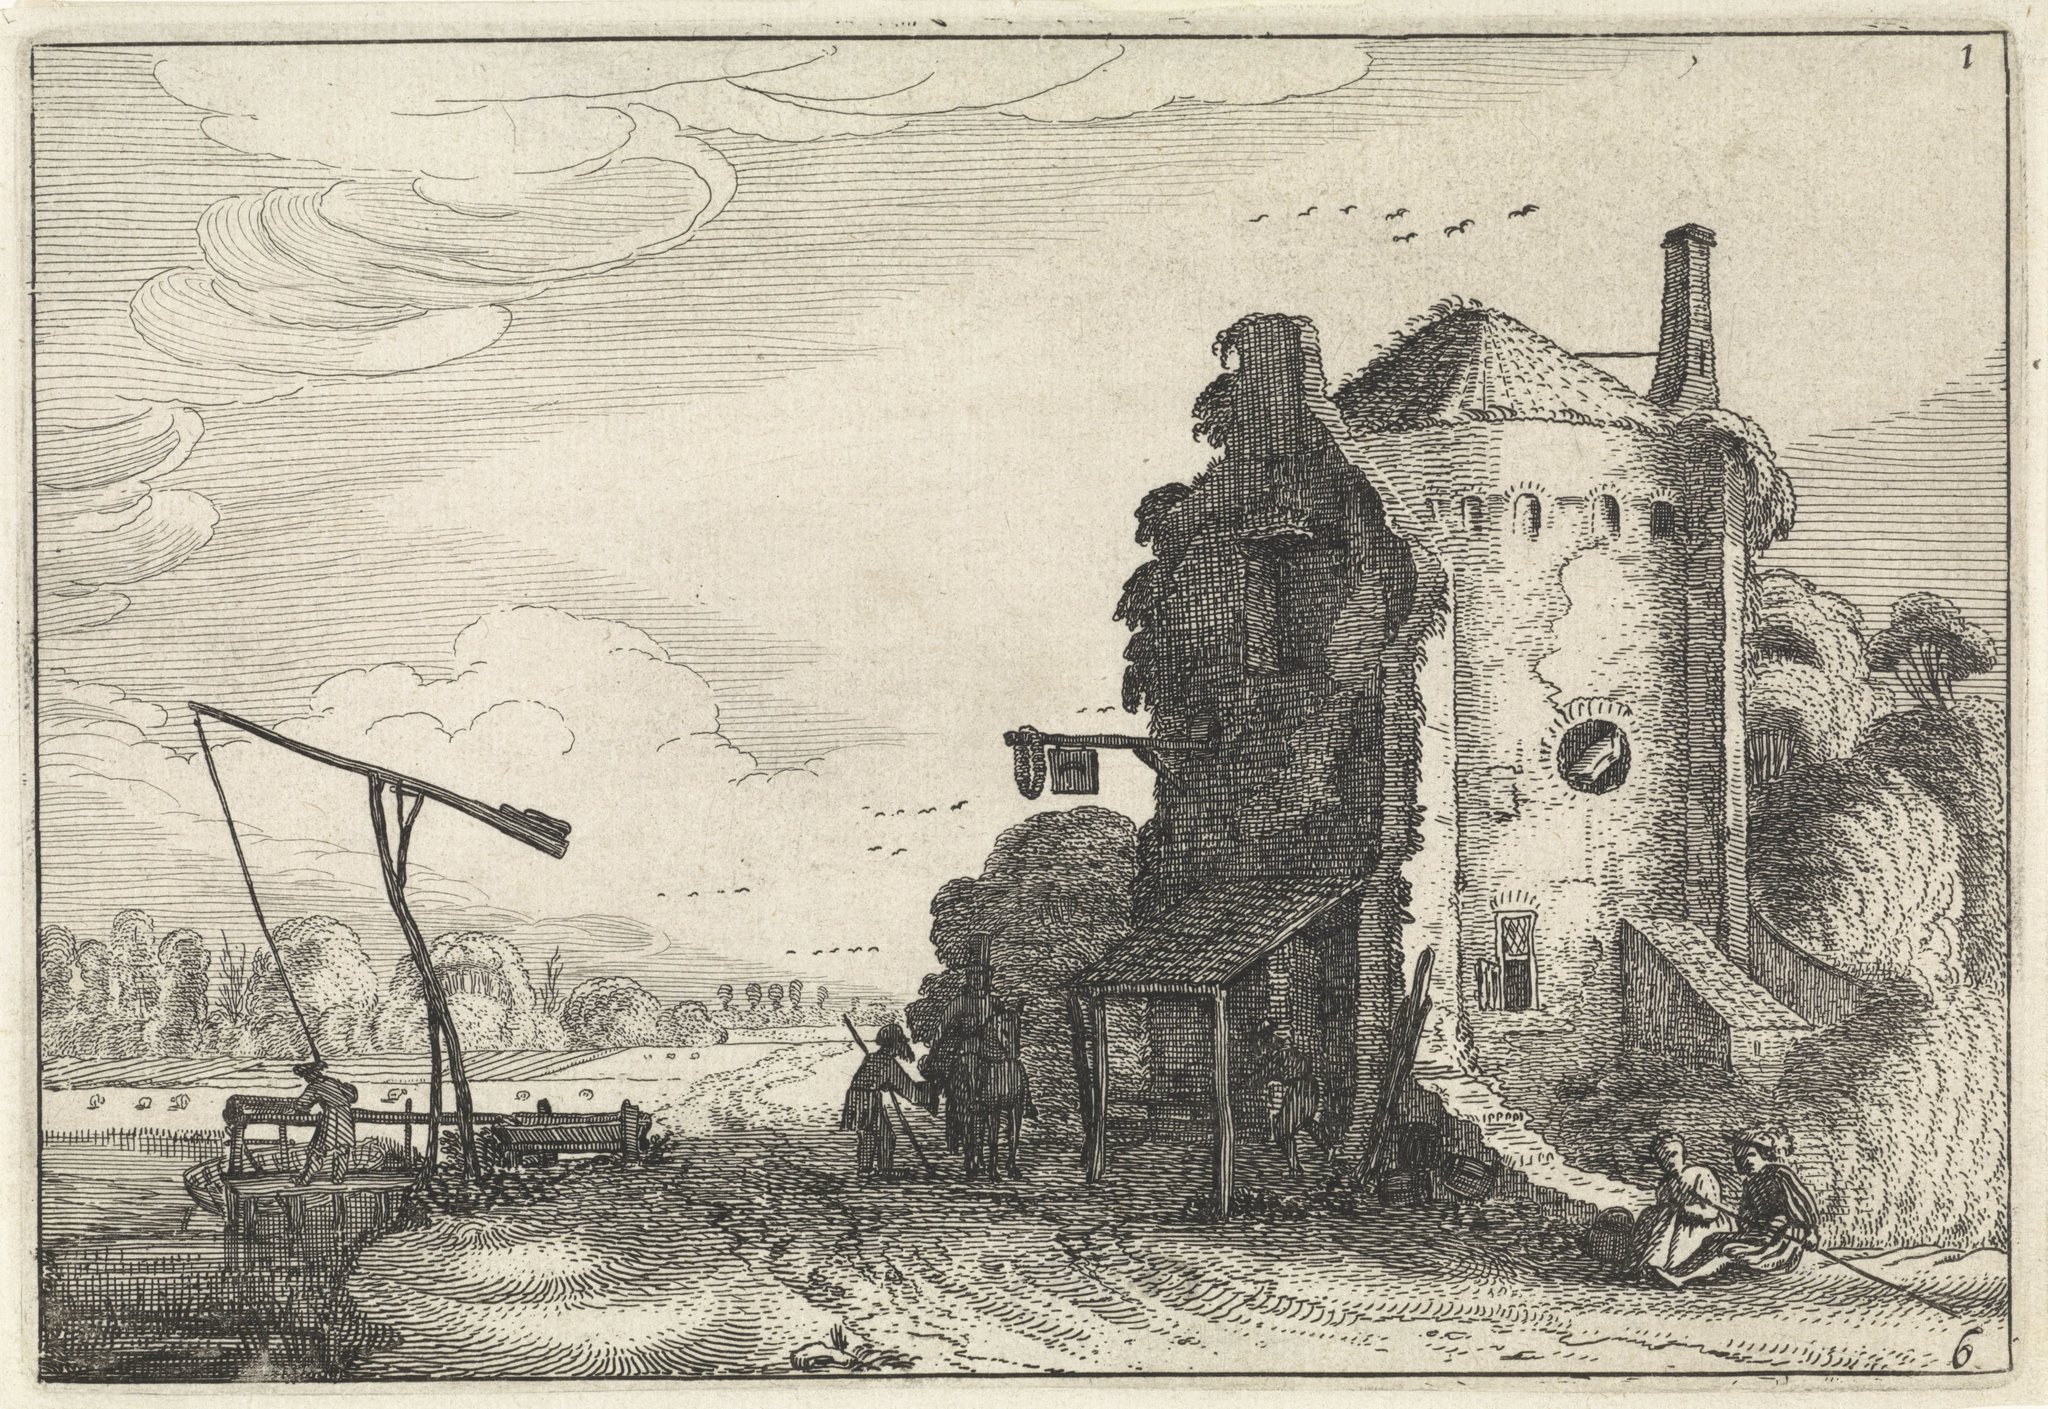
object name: print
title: Figuren bij een herberg in een ronde toren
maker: jan van de velde (ii)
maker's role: draughtsman, painter, print maker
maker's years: 1593-1641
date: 1616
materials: paper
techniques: etching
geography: northern netherlands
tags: water-supply (~ public services), landscape with tower or castle, farm or solitary house in landscape, hotel, hostelry, inn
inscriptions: collector's mark: Lugt 2228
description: Figuren bij een herberg in een ronde toren in een landschap. Links een man die water uit een rivier haalt. Zesde prent van een serie van in totaal zestig prenten met landschappen, verdeeld over vijf delen van elk twaalf prenten.